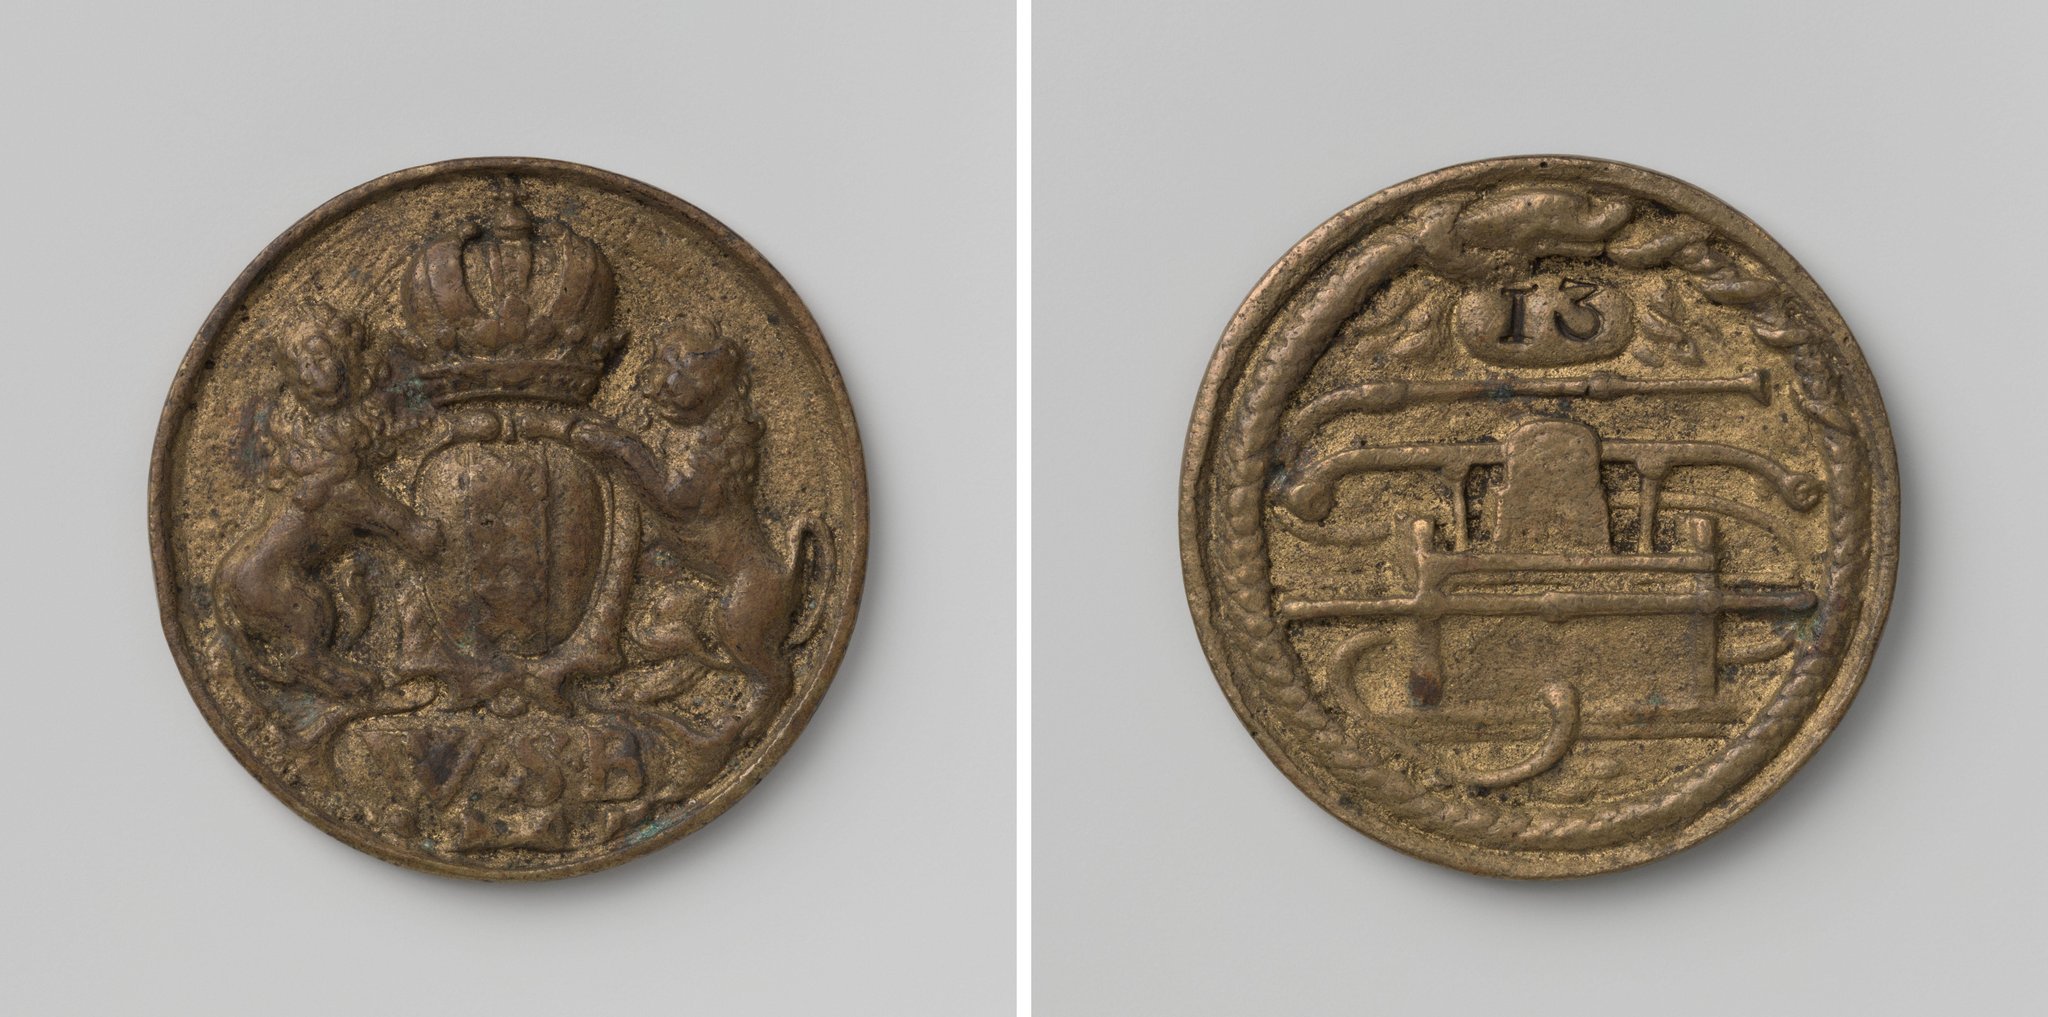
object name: medal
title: Amsterdam, brandspuitpenning met no. 13 en monogram W.S.B.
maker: Anonymous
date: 1680-1800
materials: brass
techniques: casting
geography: amsterdam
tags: amsterdam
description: Messing penning. Voorzijde: gekroond wapenschild, geflankeerd door twee leeuwen boven cartouche met opschrift W.S.B.. Keerzijde: brandspuit onder cartouche met no. 13 binnen slangerond